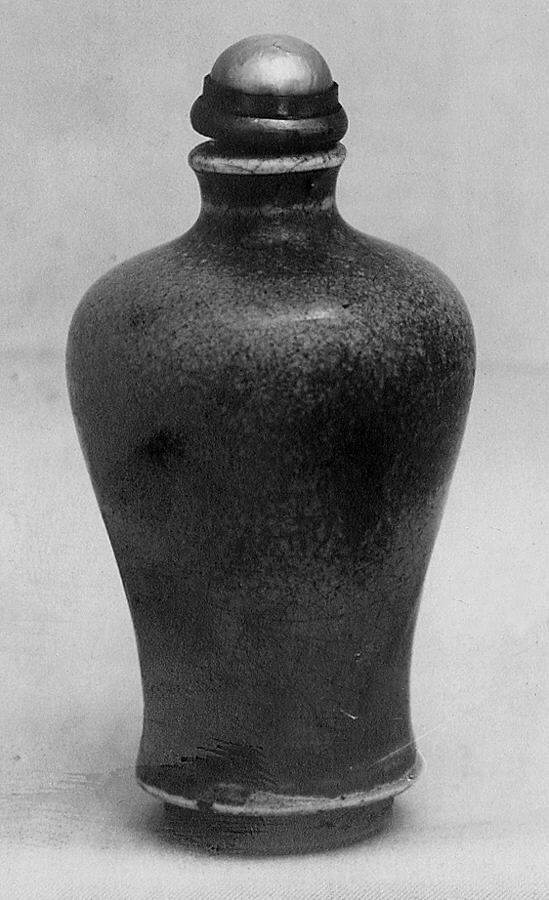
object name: snuff bottle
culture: chinese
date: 1723-1735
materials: porcelain